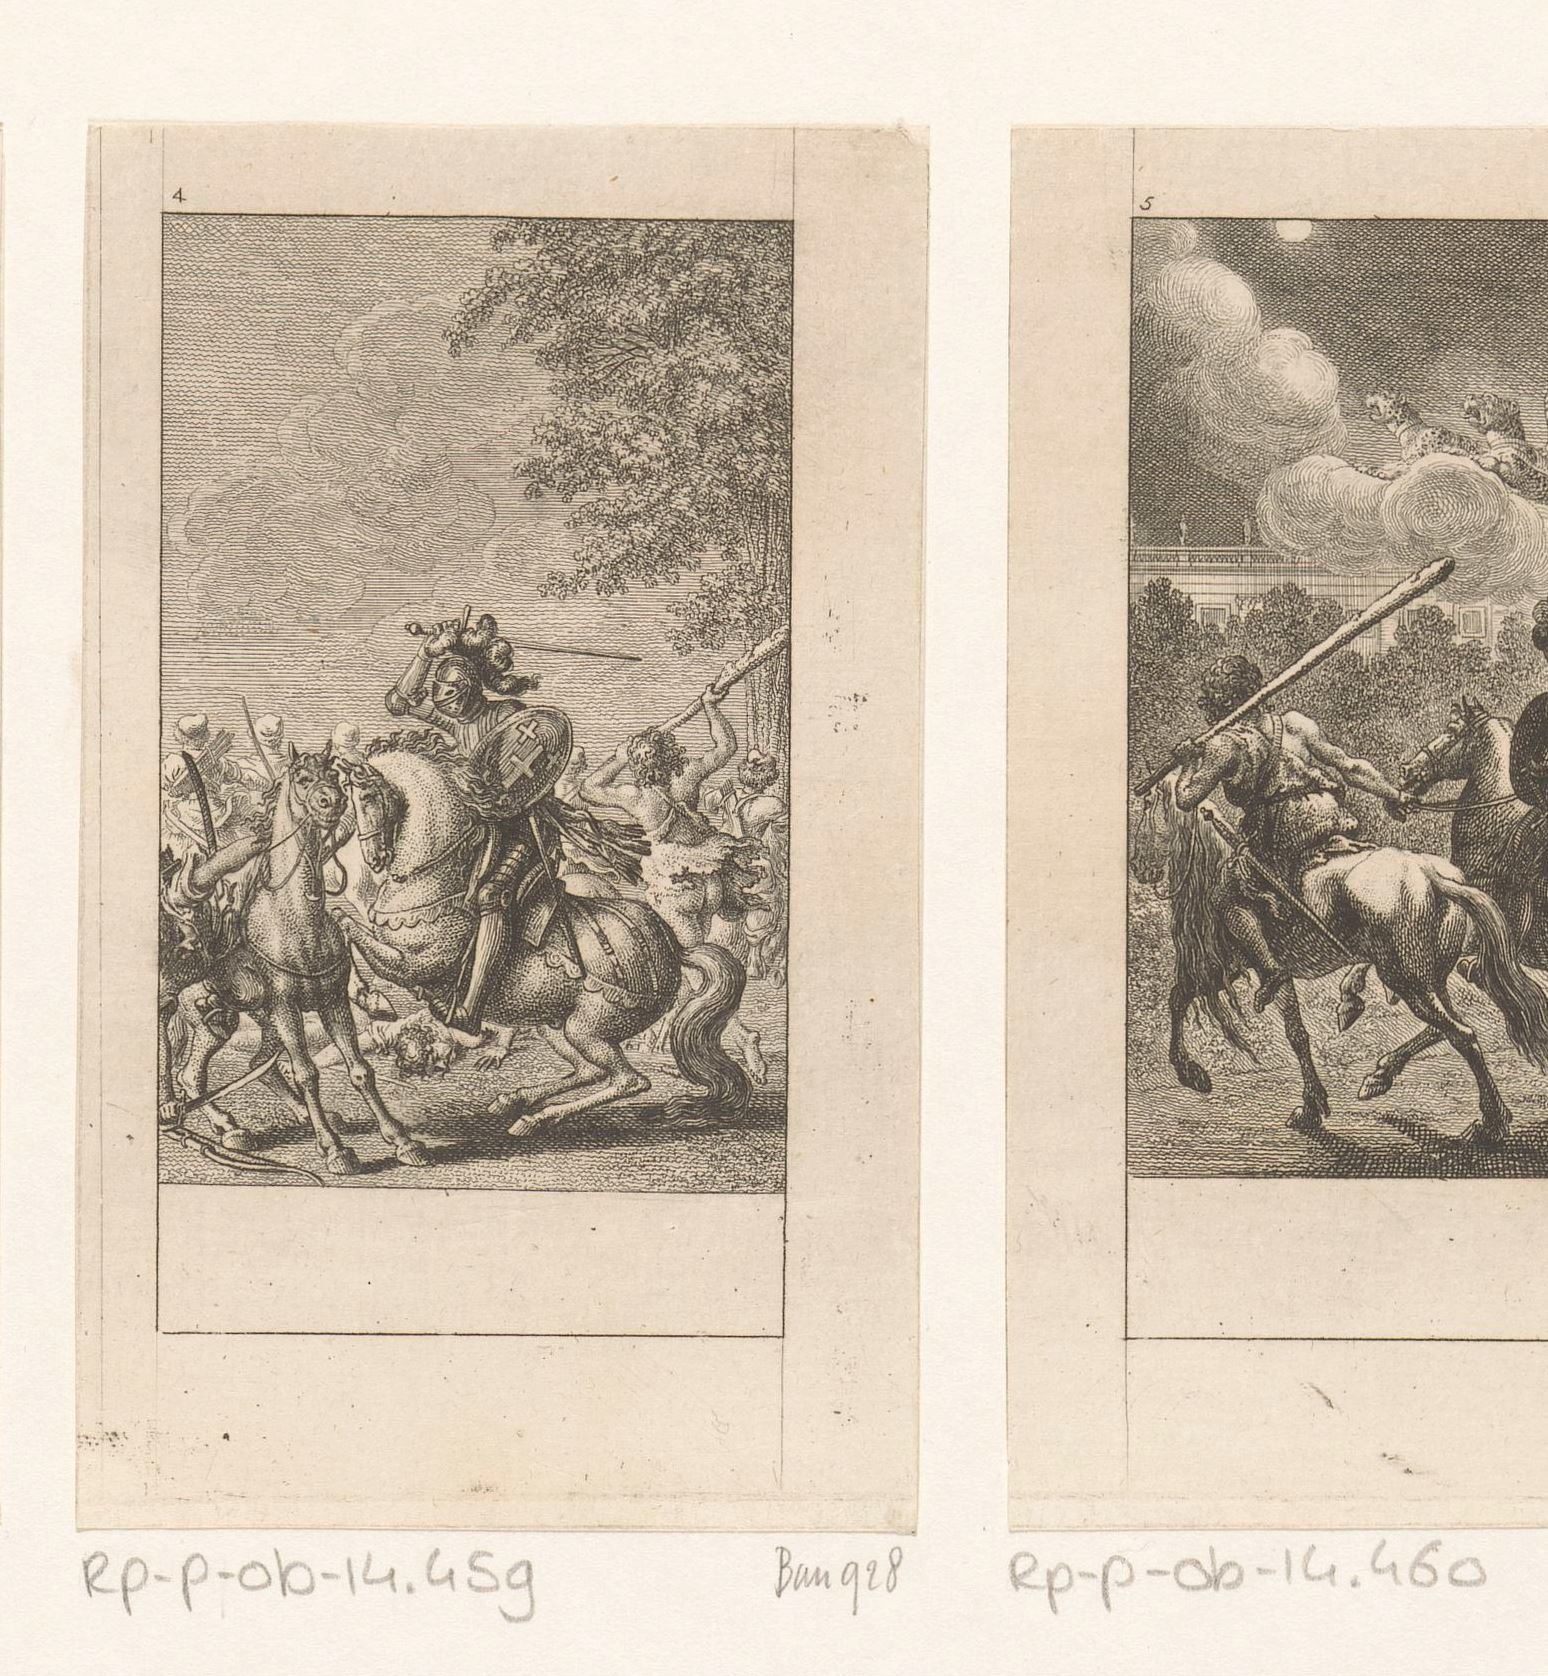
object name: print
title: Huon de Bordeaux en Gérasme in gevecht met de Arabieren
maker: daniel nikolaus chodowiecki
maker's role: draughtsman, print maker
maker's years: 1726-1801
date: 1782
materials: paper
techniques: etching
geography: berlin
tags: wild man, wodewose, woodehouse, battle, asiatic races and peoples (with name)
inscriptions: collector's mark: Lugt 2228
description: Vervaardigd voor Tressans 'Huon de Bordeaux'. Latere staat gebruikt voor: Almanac de Gotha contenant diverses connaissances curieuses et utiles pour l'année MDCCLXXXIII. Gotha: C. W. Ettinger, 1782.